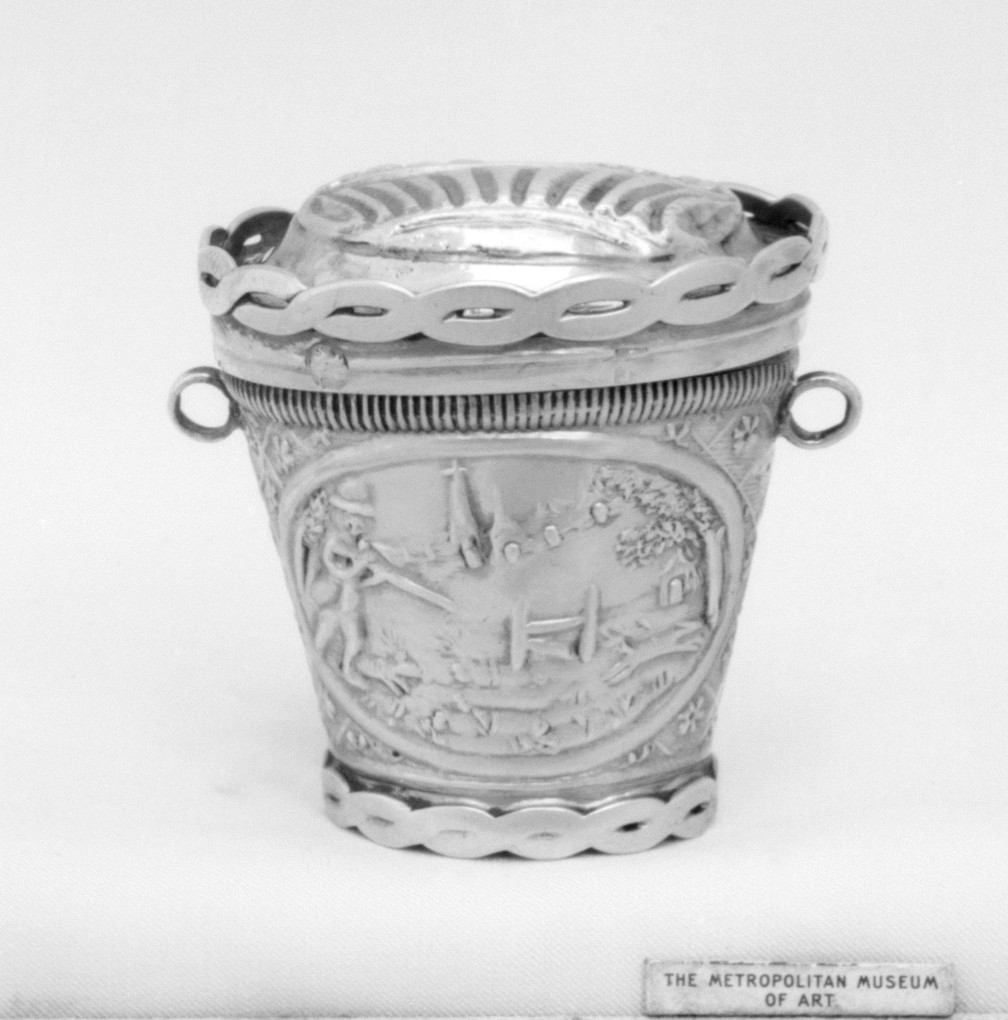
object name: pomander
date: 1840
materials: silver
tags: trees